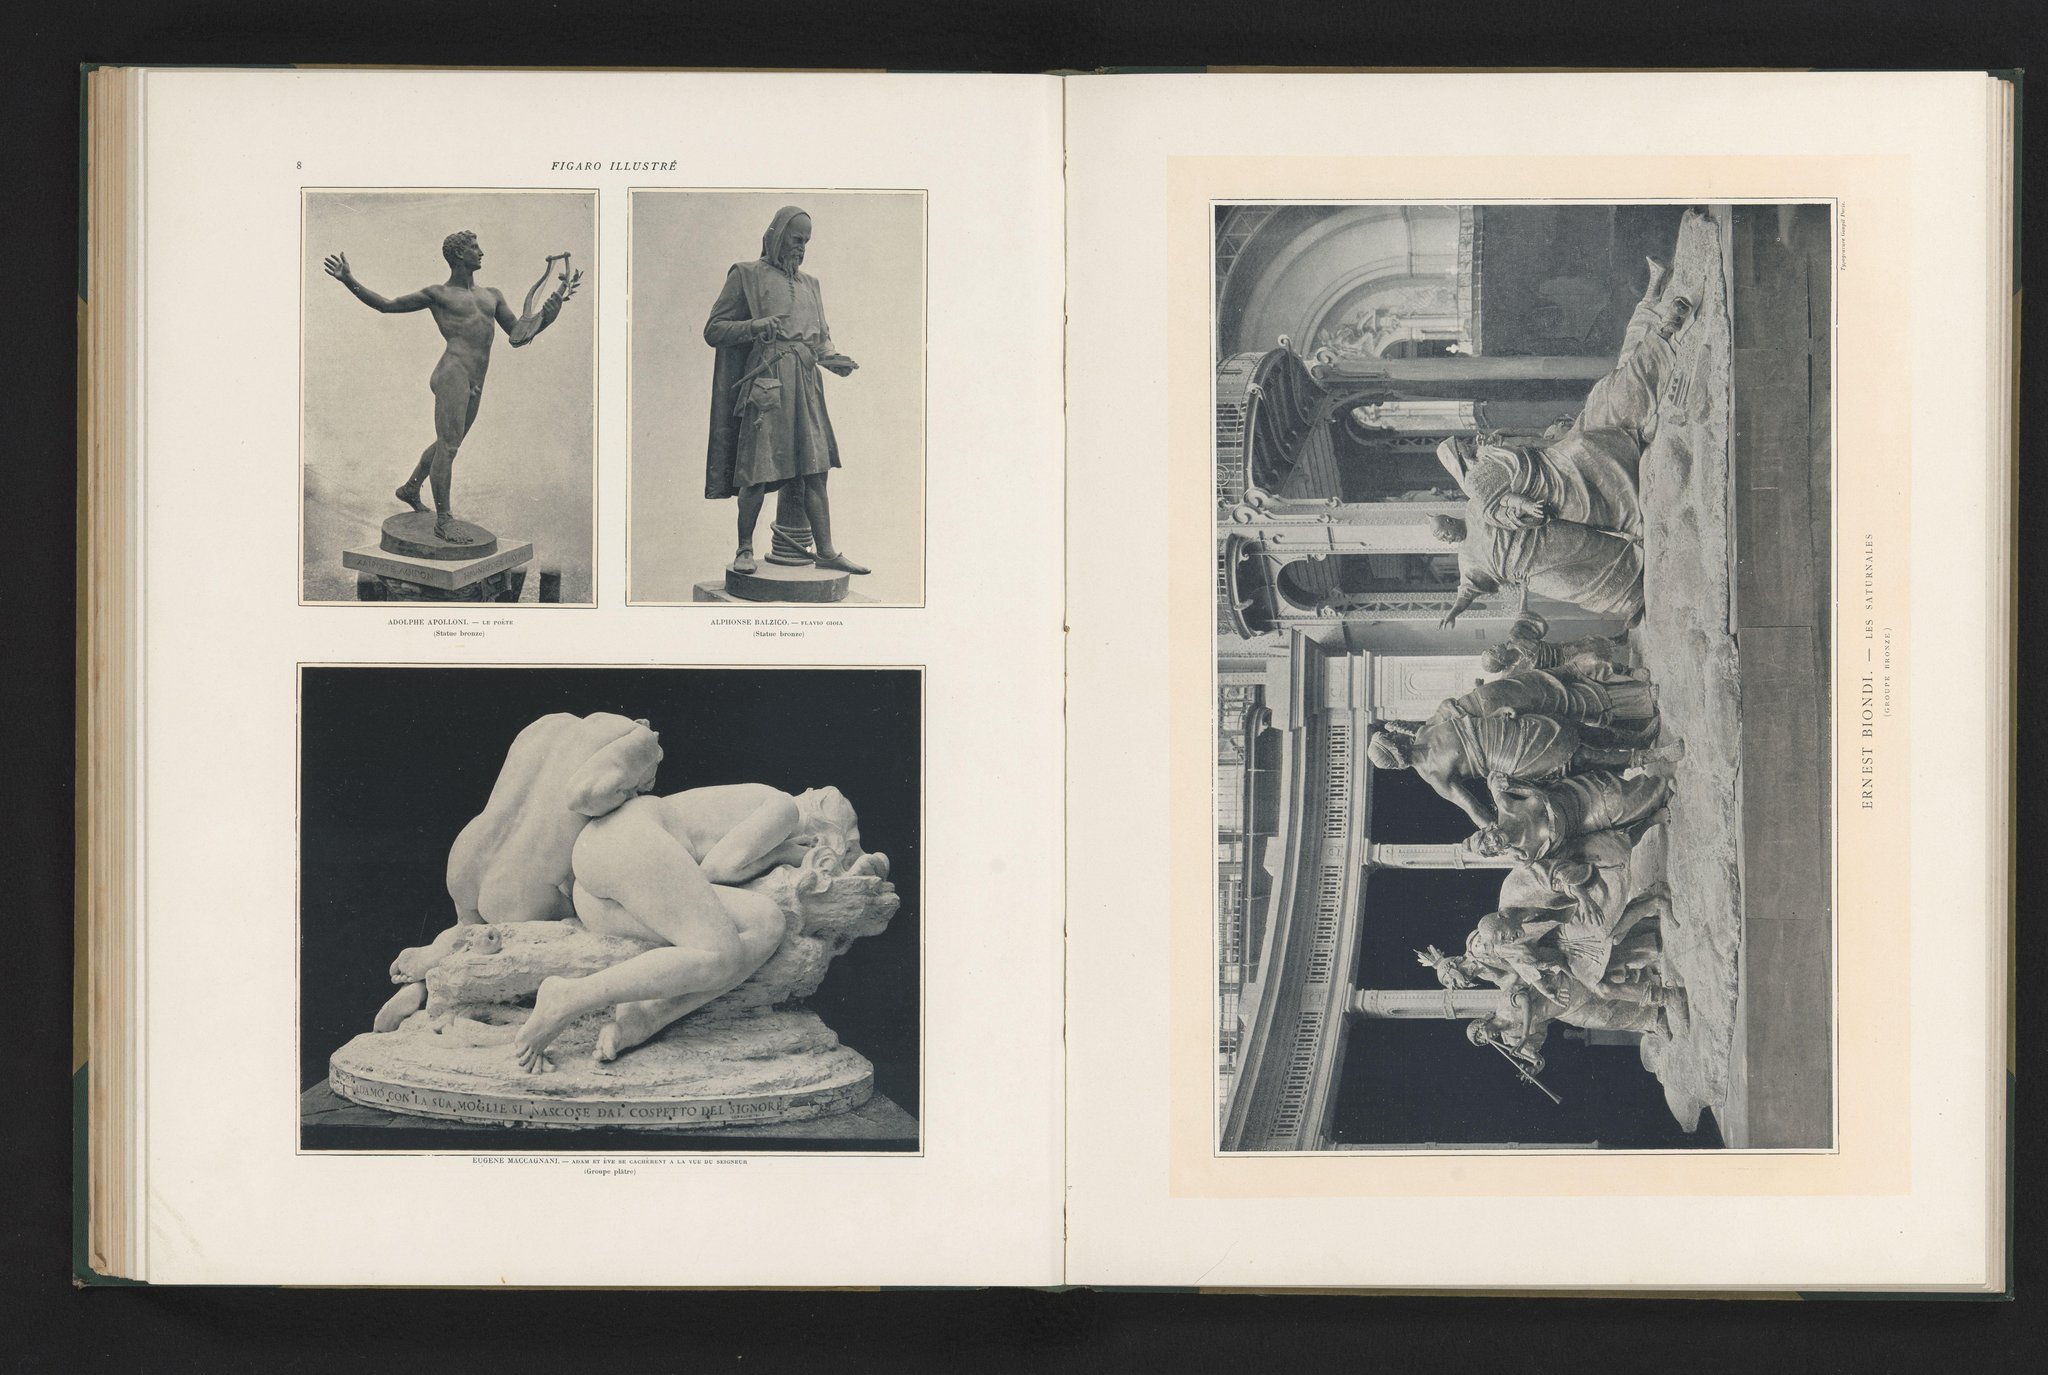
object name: page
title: Bronzen beeld van de saturnaliën van Ernesto Biondi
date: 1885-1901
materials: paper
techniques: autotype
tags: sculpture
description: Prent op pagina 9 van Figaro-Illustré (Novembre 1900).